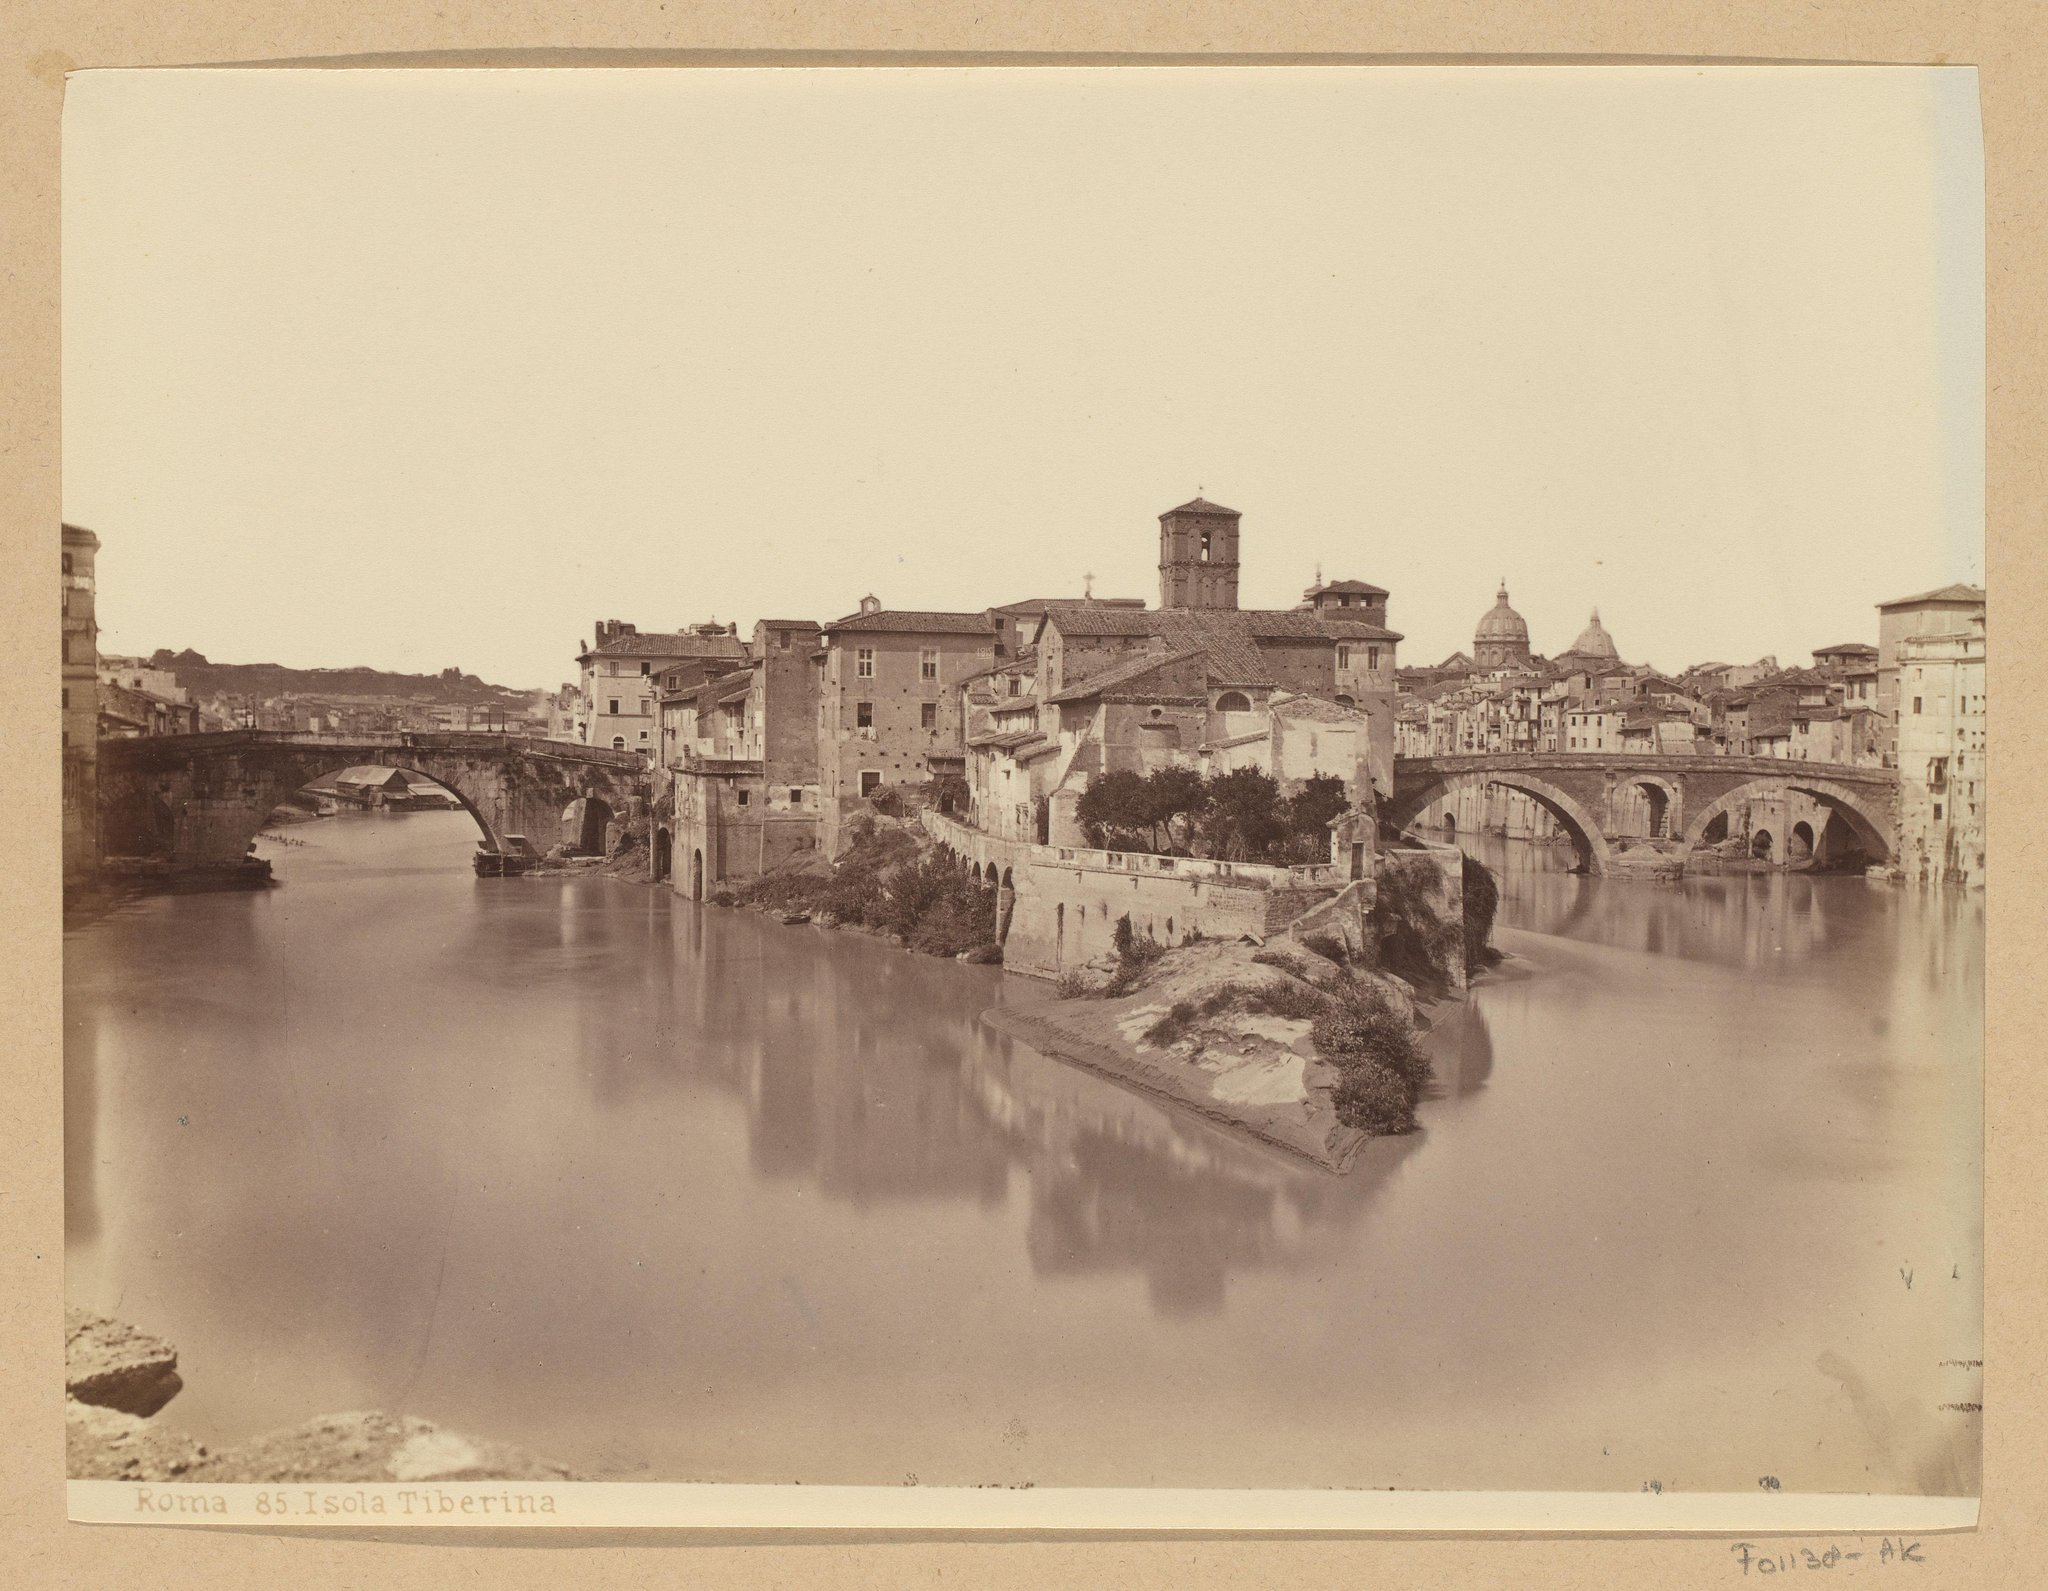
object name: photograph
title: Roma Isola Tiberina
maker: Anonymous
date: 1860-1900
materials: photographic support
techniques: albumen print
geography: rome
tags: island, landscape with bridge, viaduct or aqueduct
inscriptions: number: ‘85’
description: Onderdeel van Reisalbum met opnames van kunstwerken en bezienswaardigheden in Italië, Griekenland en Frankrijk.